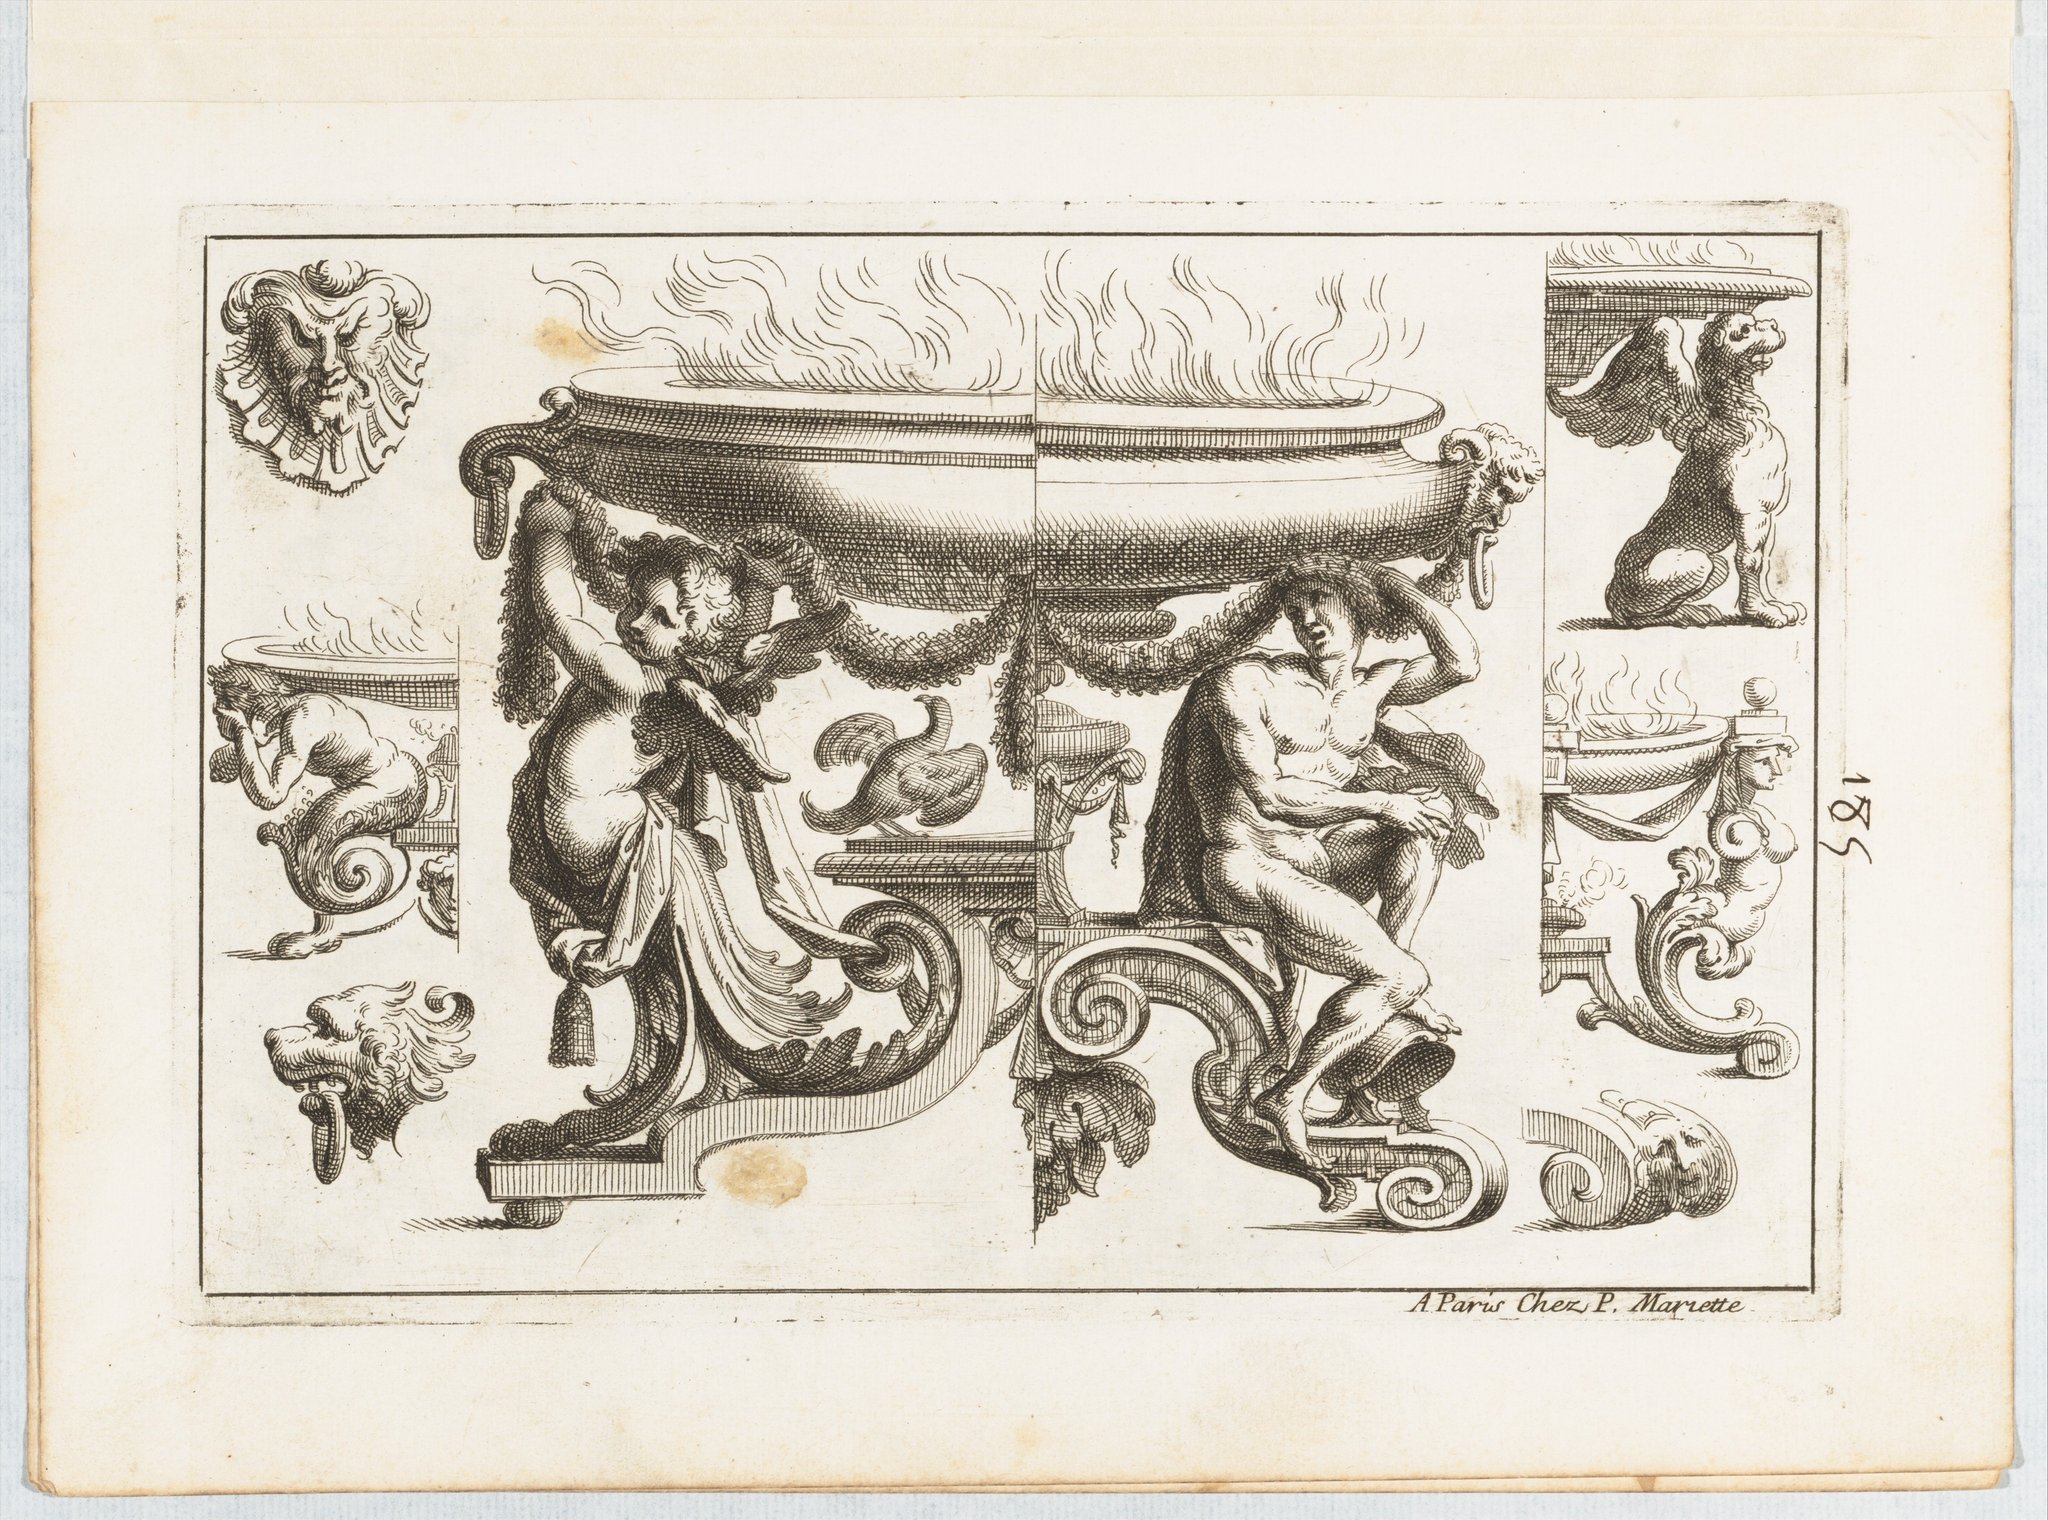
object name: print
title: Plate 5, from "Desseins de Brasiers dont les Ornements peuuent Seruir aux Cuuettes, Tables, et autres Ouurages d'Orfeurerie"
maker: alexis loir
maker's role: artist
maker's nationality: french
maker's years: 1640-1713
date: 1660-1713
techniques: etching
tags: birds,ornament,men,putti